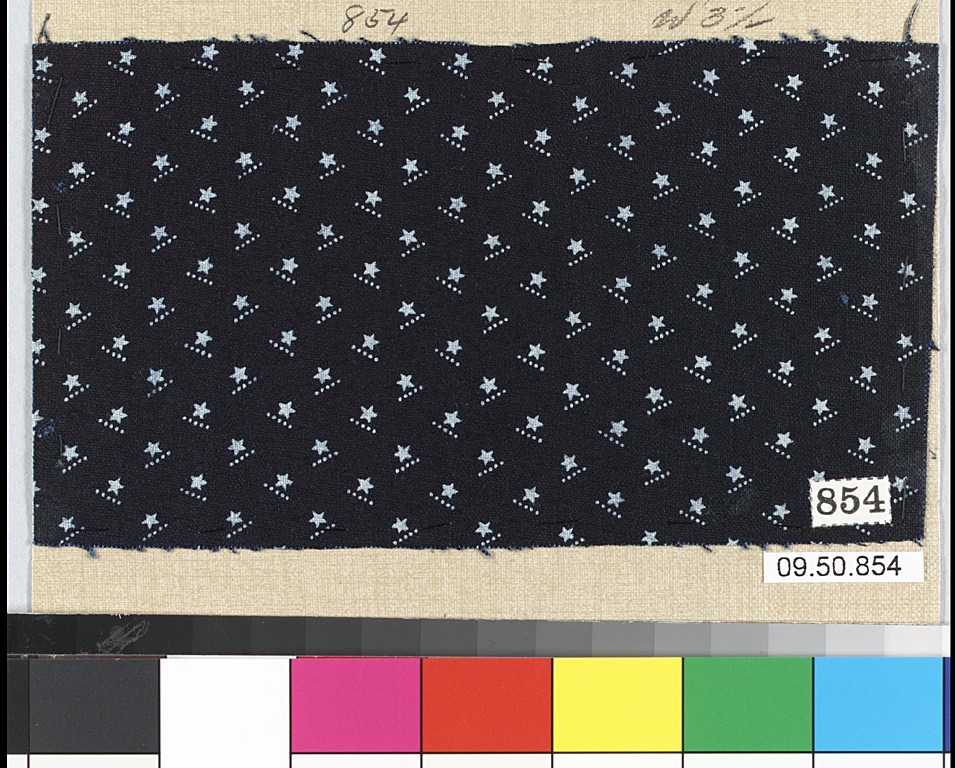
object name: piece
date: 1801-1900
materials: cotton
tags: stars